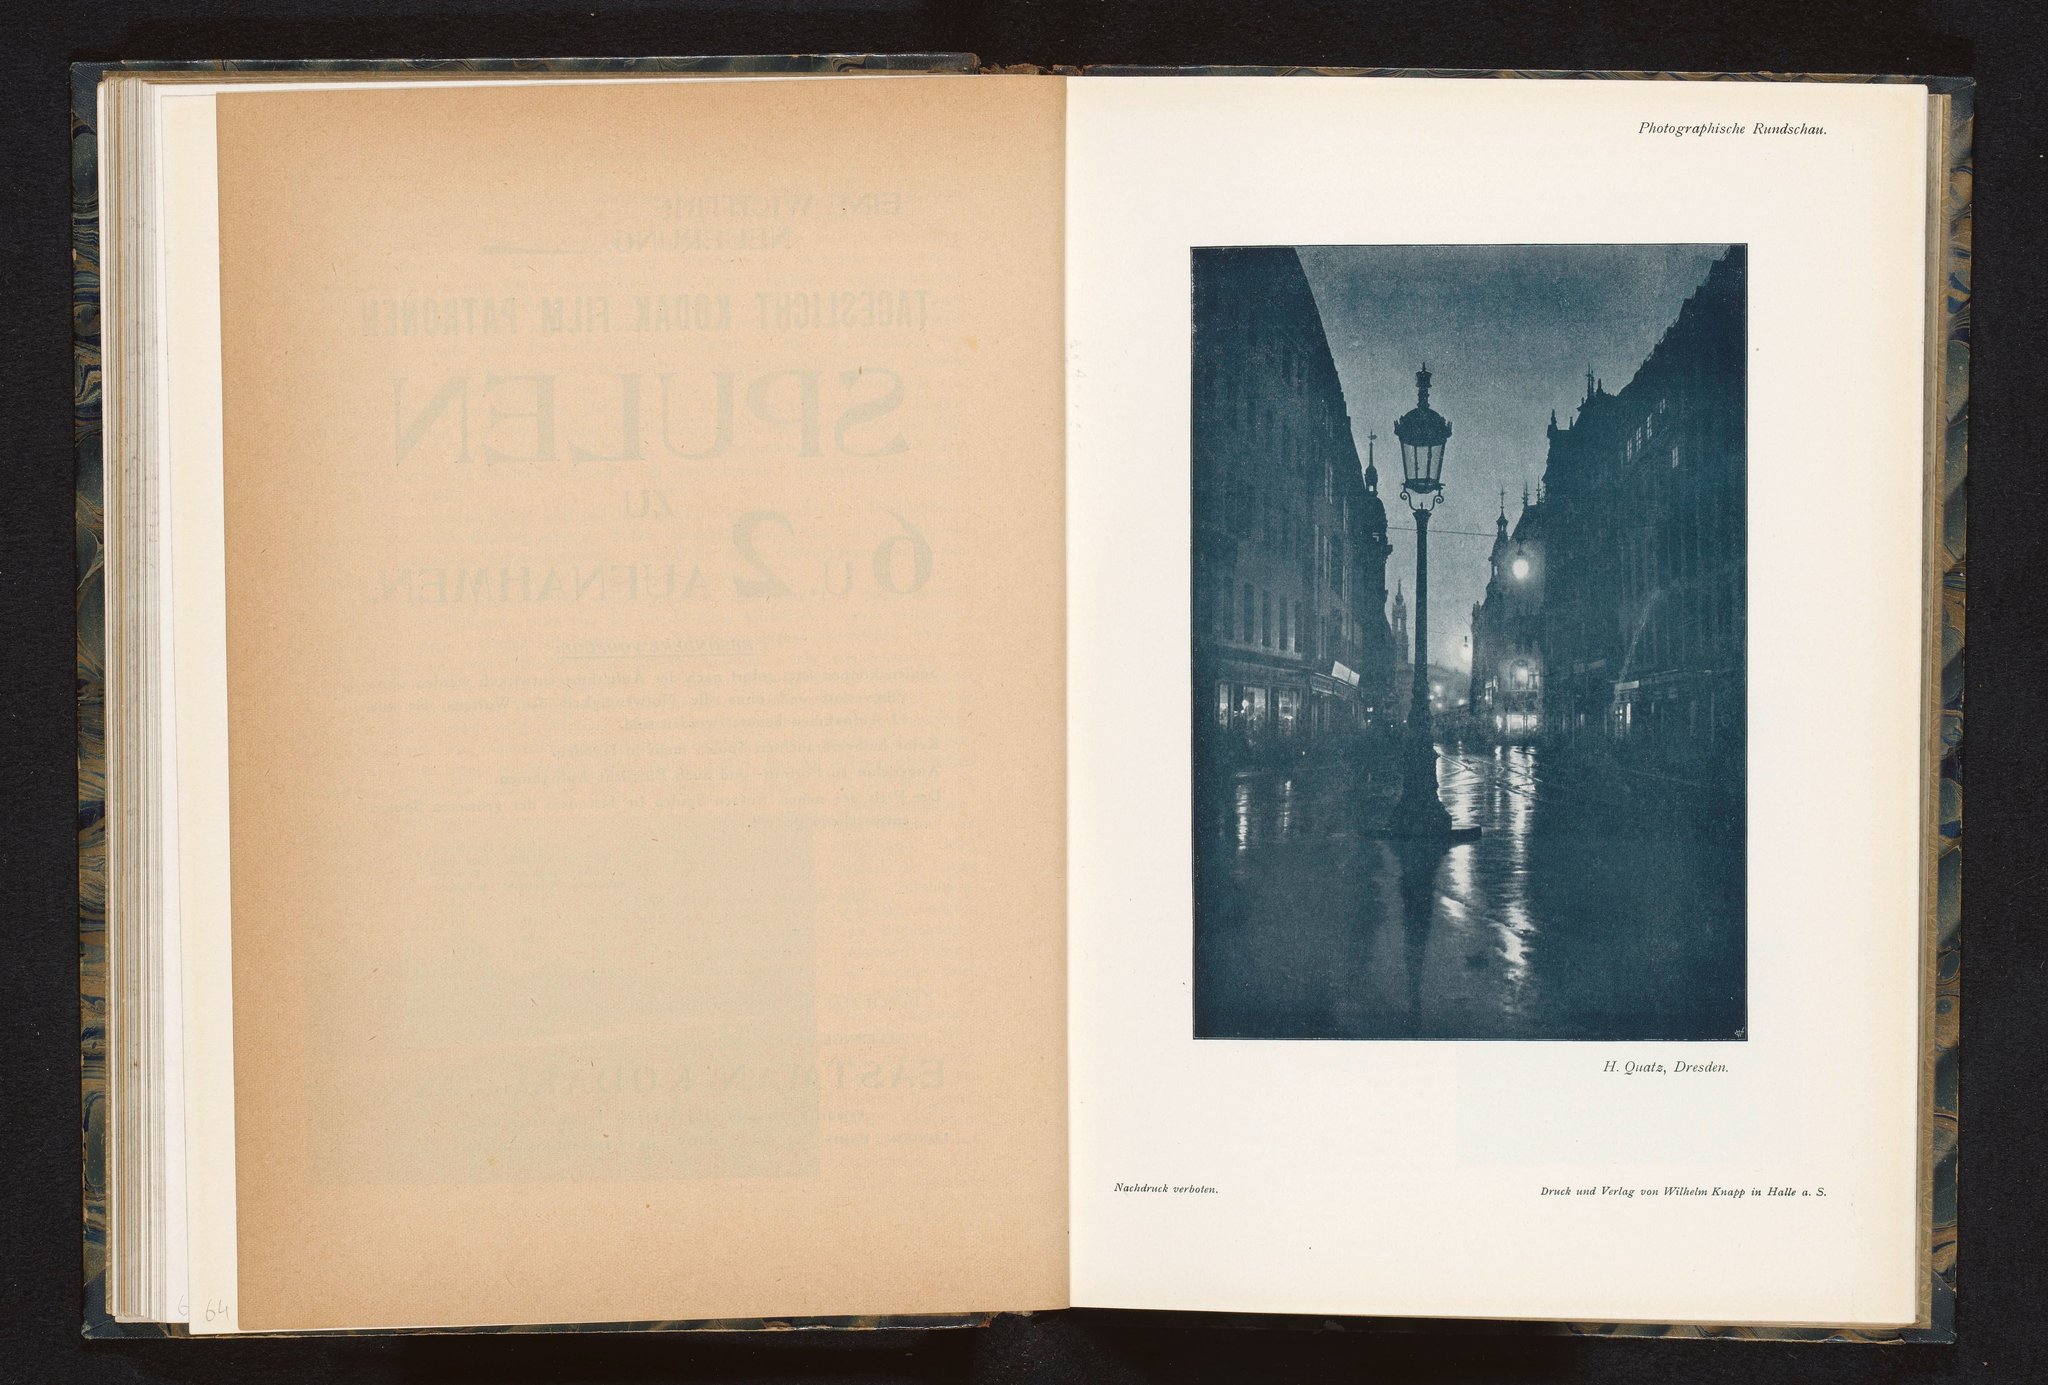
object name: photomechanical print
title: Gezicht op een straat met lantaarn, vermoedelijk in Dresden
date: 1895-1900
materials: paper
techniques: autotype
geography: halle an der saale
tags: street lighting, street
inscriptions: monogram: ‘WC’